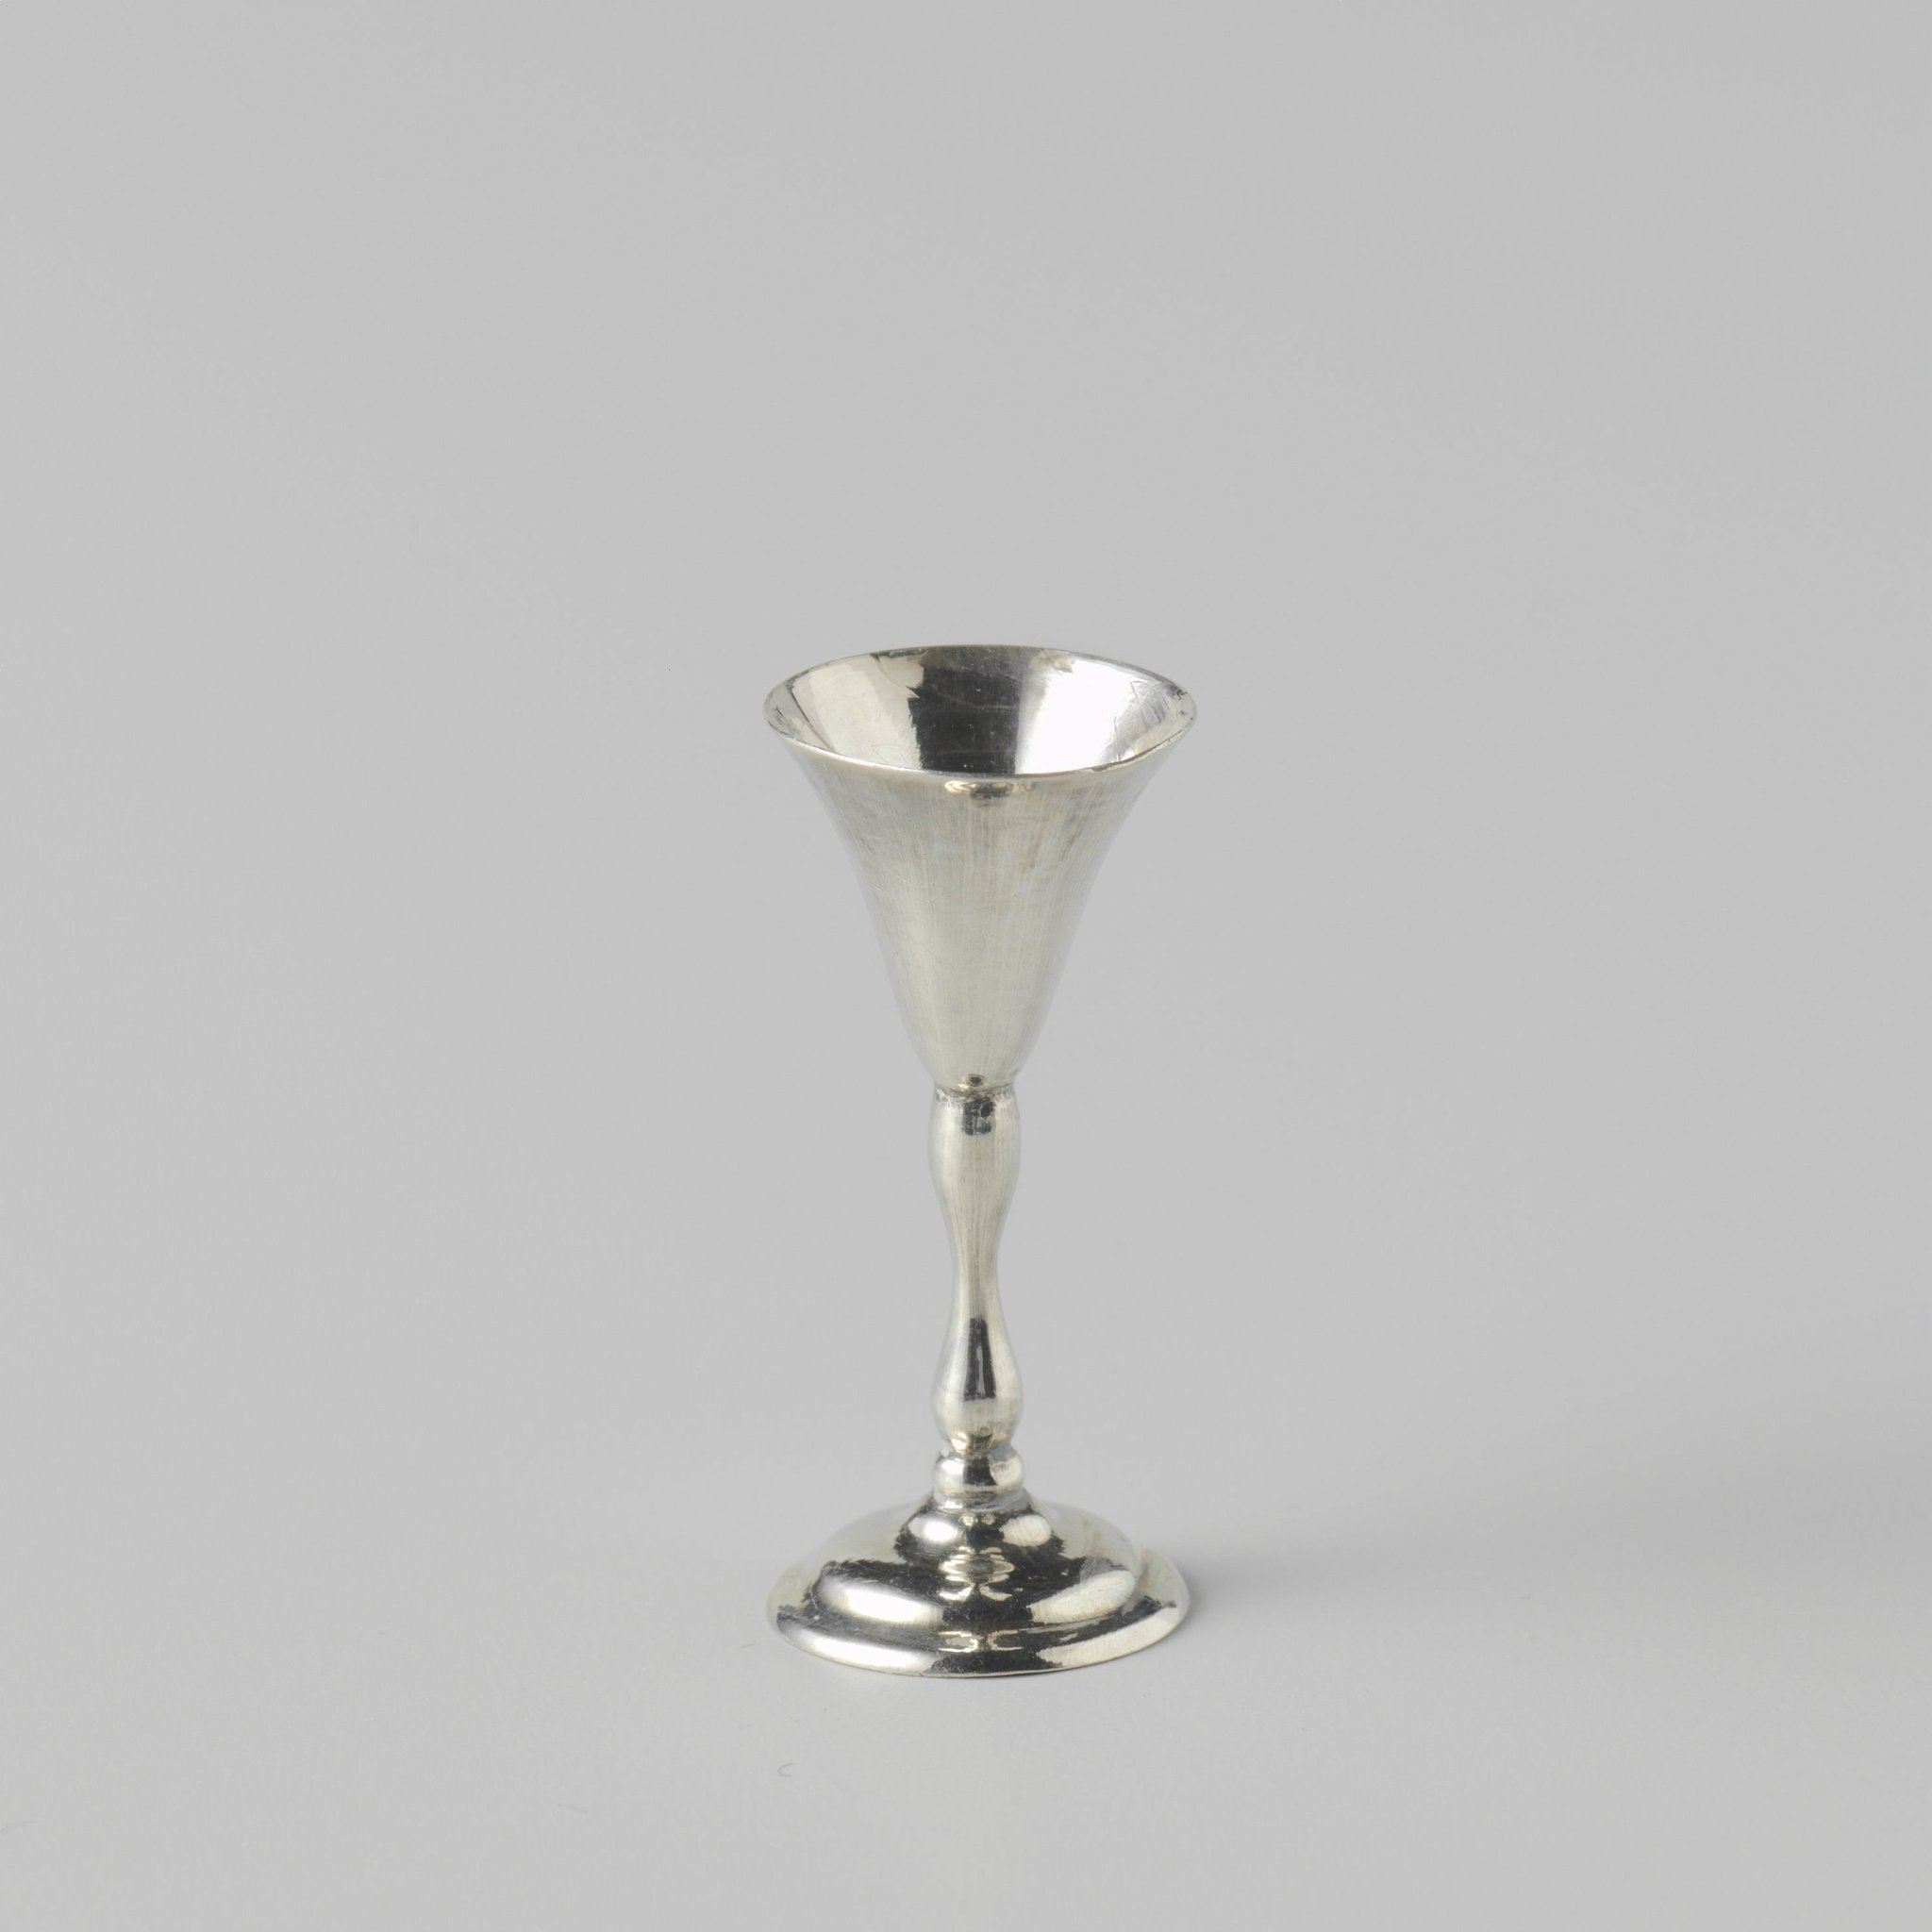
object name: miniature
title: Drinkglas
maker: Anonymous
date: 1725-1775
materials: silver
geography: netherlands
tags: glass, rummer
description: Trechtervormig drinkglas op een hoge balustervormige stam. De voet is rond en gewelfd. Het drinkglas is gelijk aan vijf andere exemplaren (BK-NM-11177-181-b-III, BK-NM-11177-181-b-IV, BK-NM-11177-b-V, BK-NM-11177-181-b-VI, BK-NM-11177-181-b-VII). De drinkglazen staan met een schenkkan (BK-NM-11177-181-b-II) op een dienblad (BK-NM-11177-181-b-I). Het dienblad staat op een klaptafel (BK-NM-11177-a).